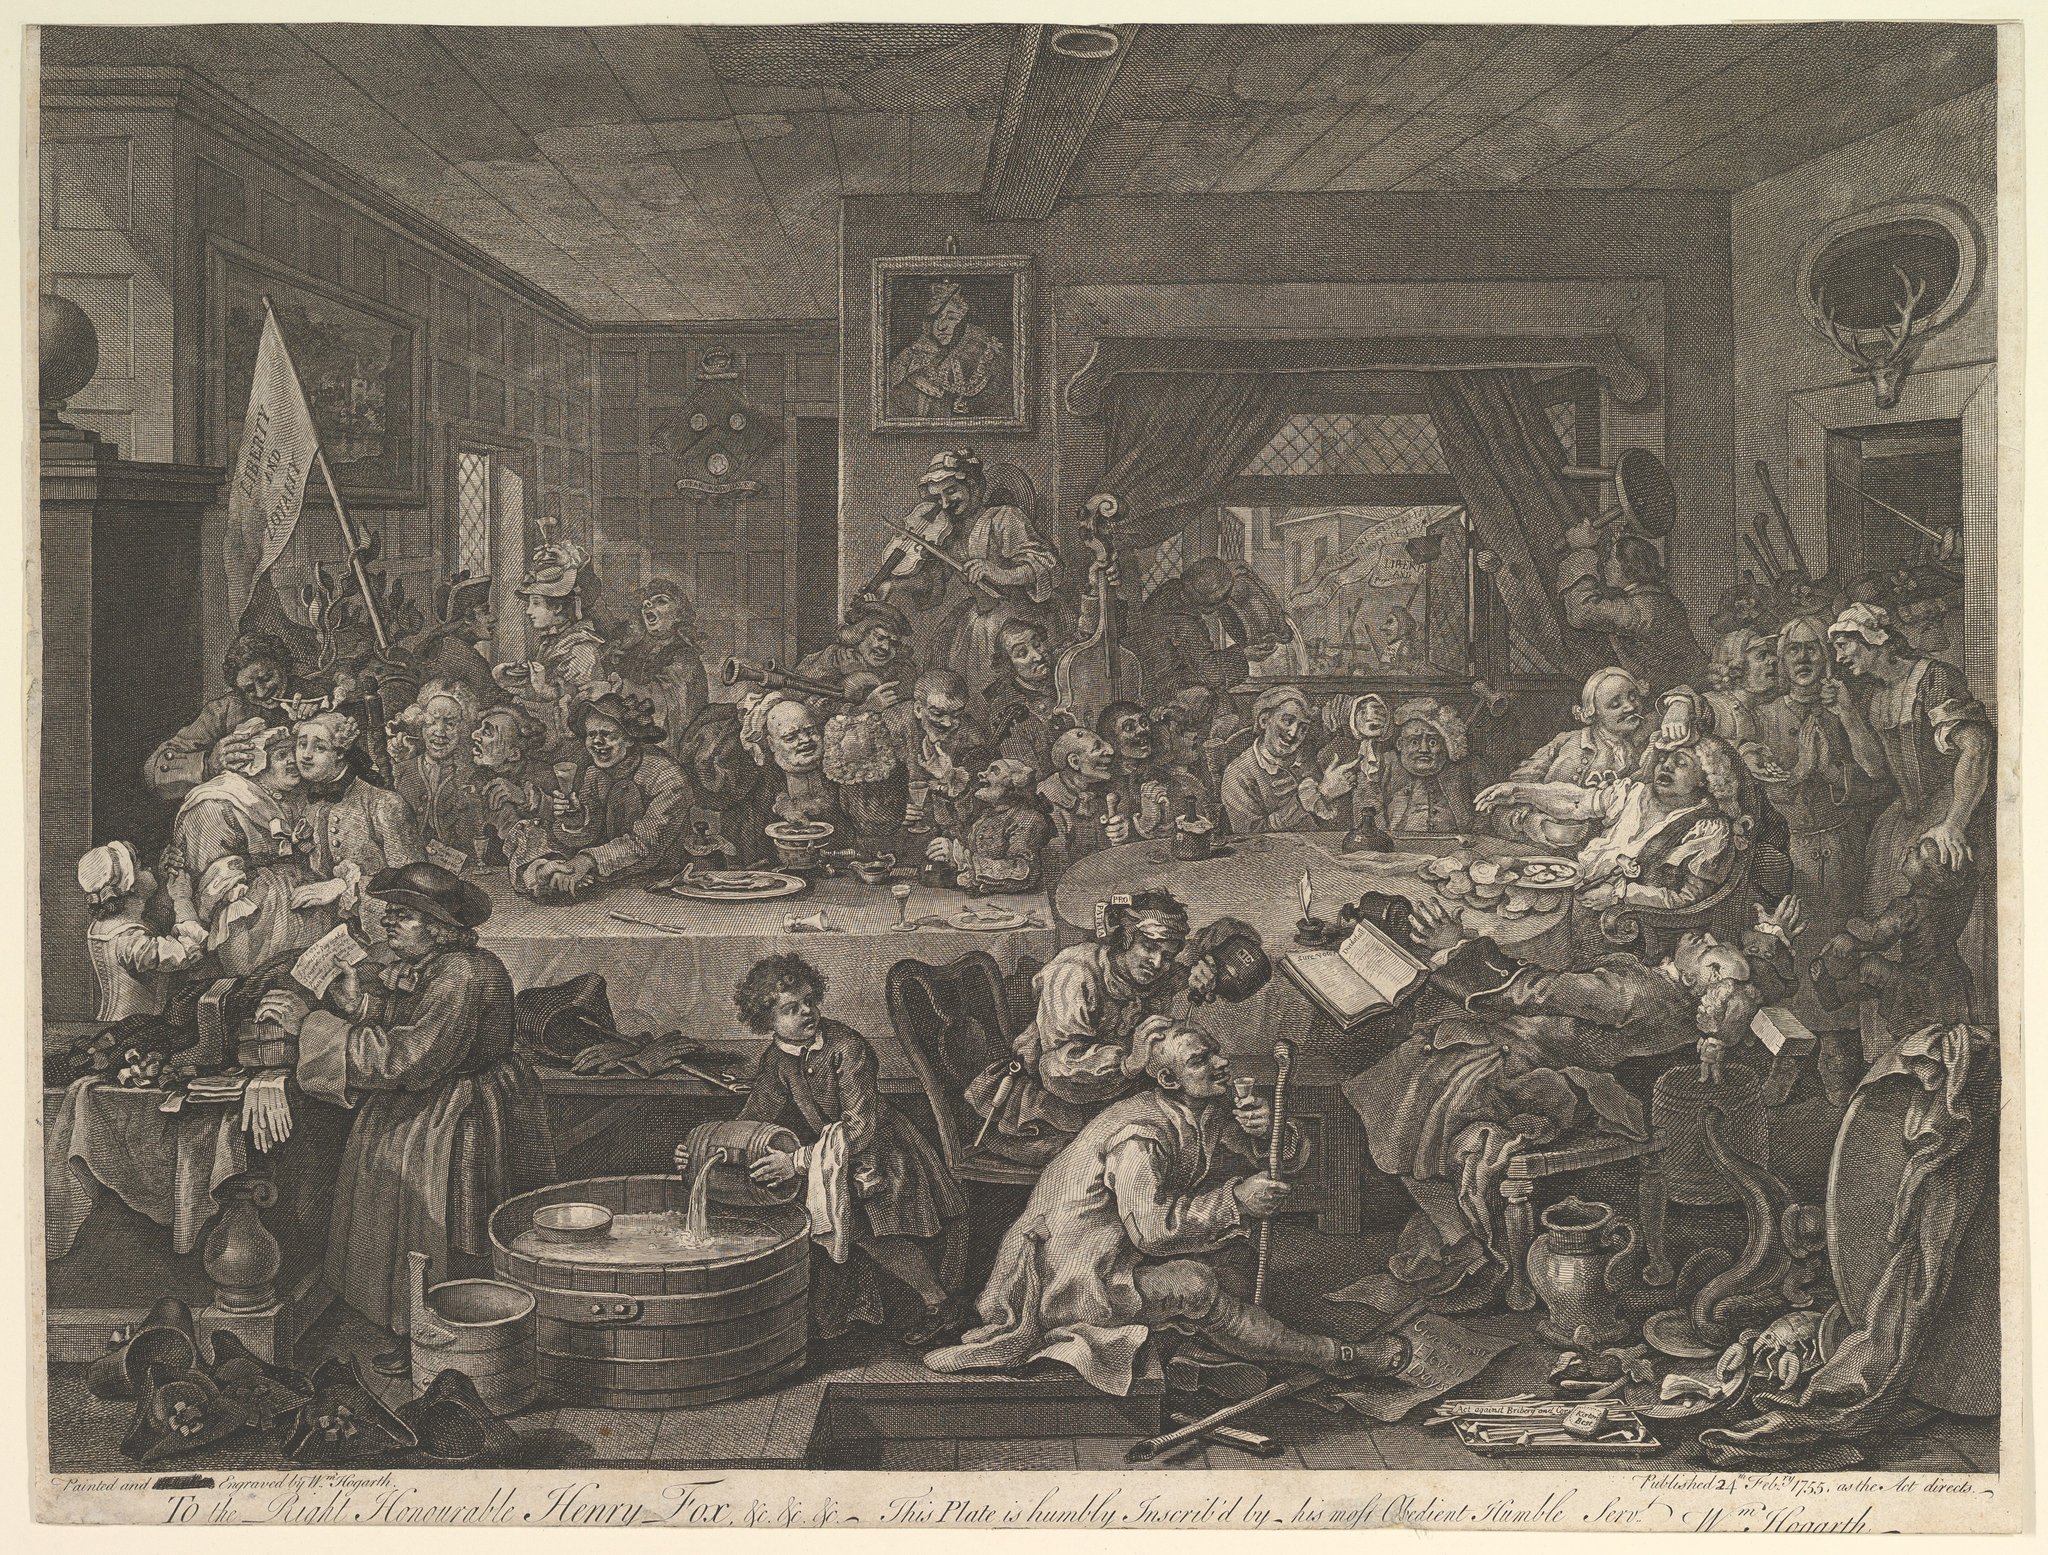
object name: print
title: An Election Entertainment, Plate I: Four Prints of an Election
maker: william hogarth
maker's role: artist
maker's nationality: british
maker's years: 1697-1764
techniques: engraving, etching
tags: men,women,party,drinking